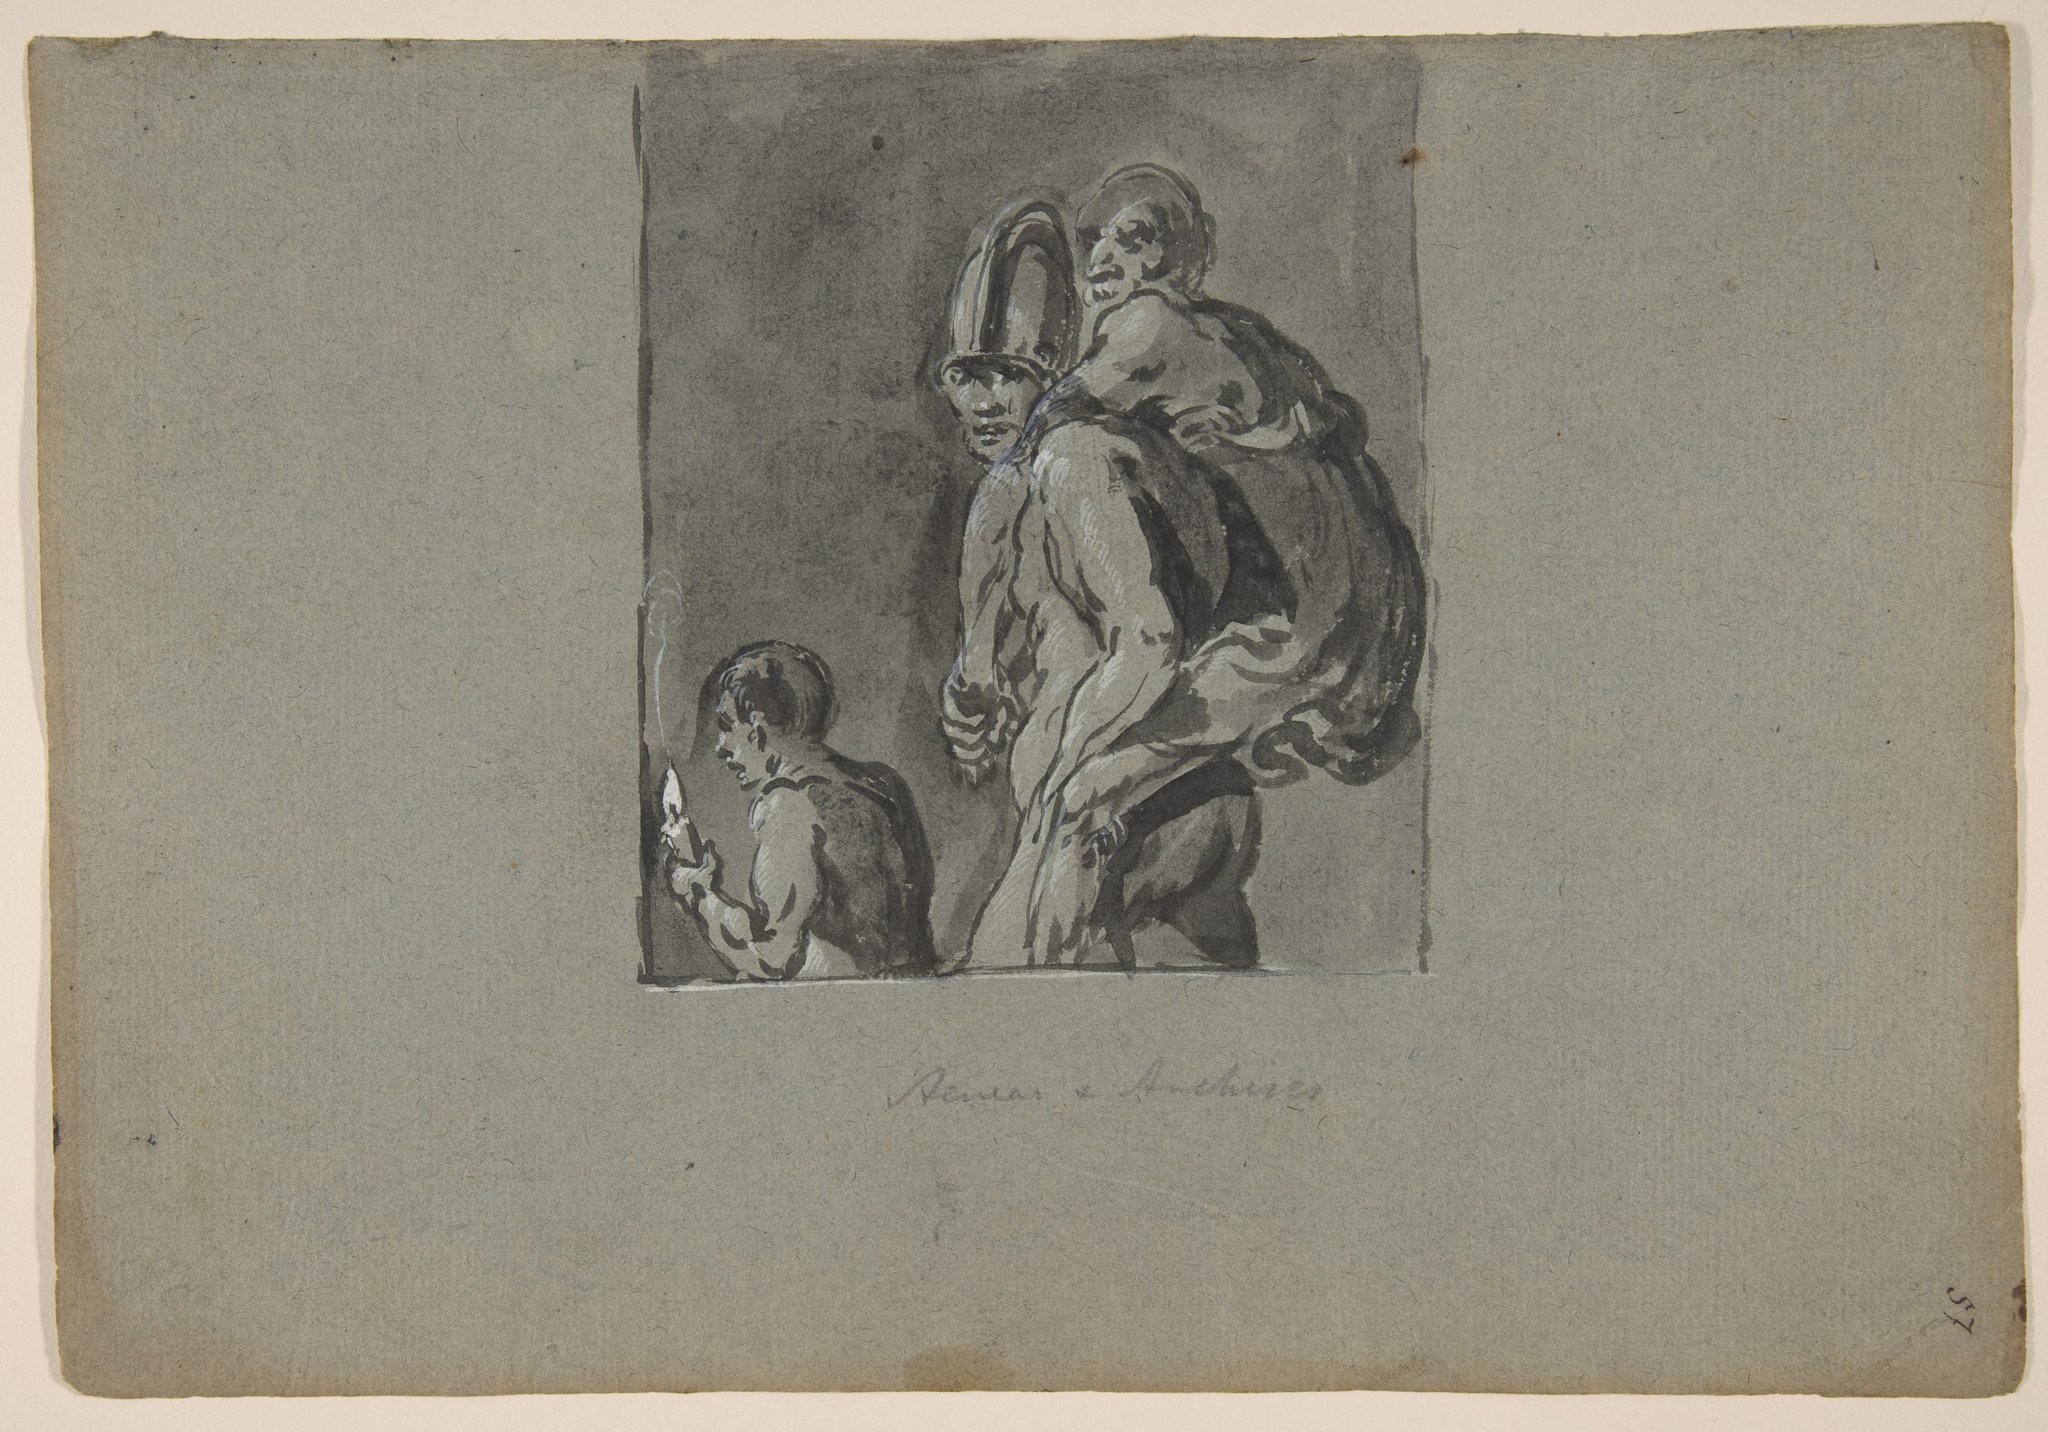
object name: drawing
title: Aeneas and Anchises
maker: leonaert bramer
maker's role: artist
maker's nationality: dutch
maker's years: 1596-1674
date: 1611-1674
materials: paint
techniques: brush, heightening, wash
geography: netherlands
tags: men,aeneas